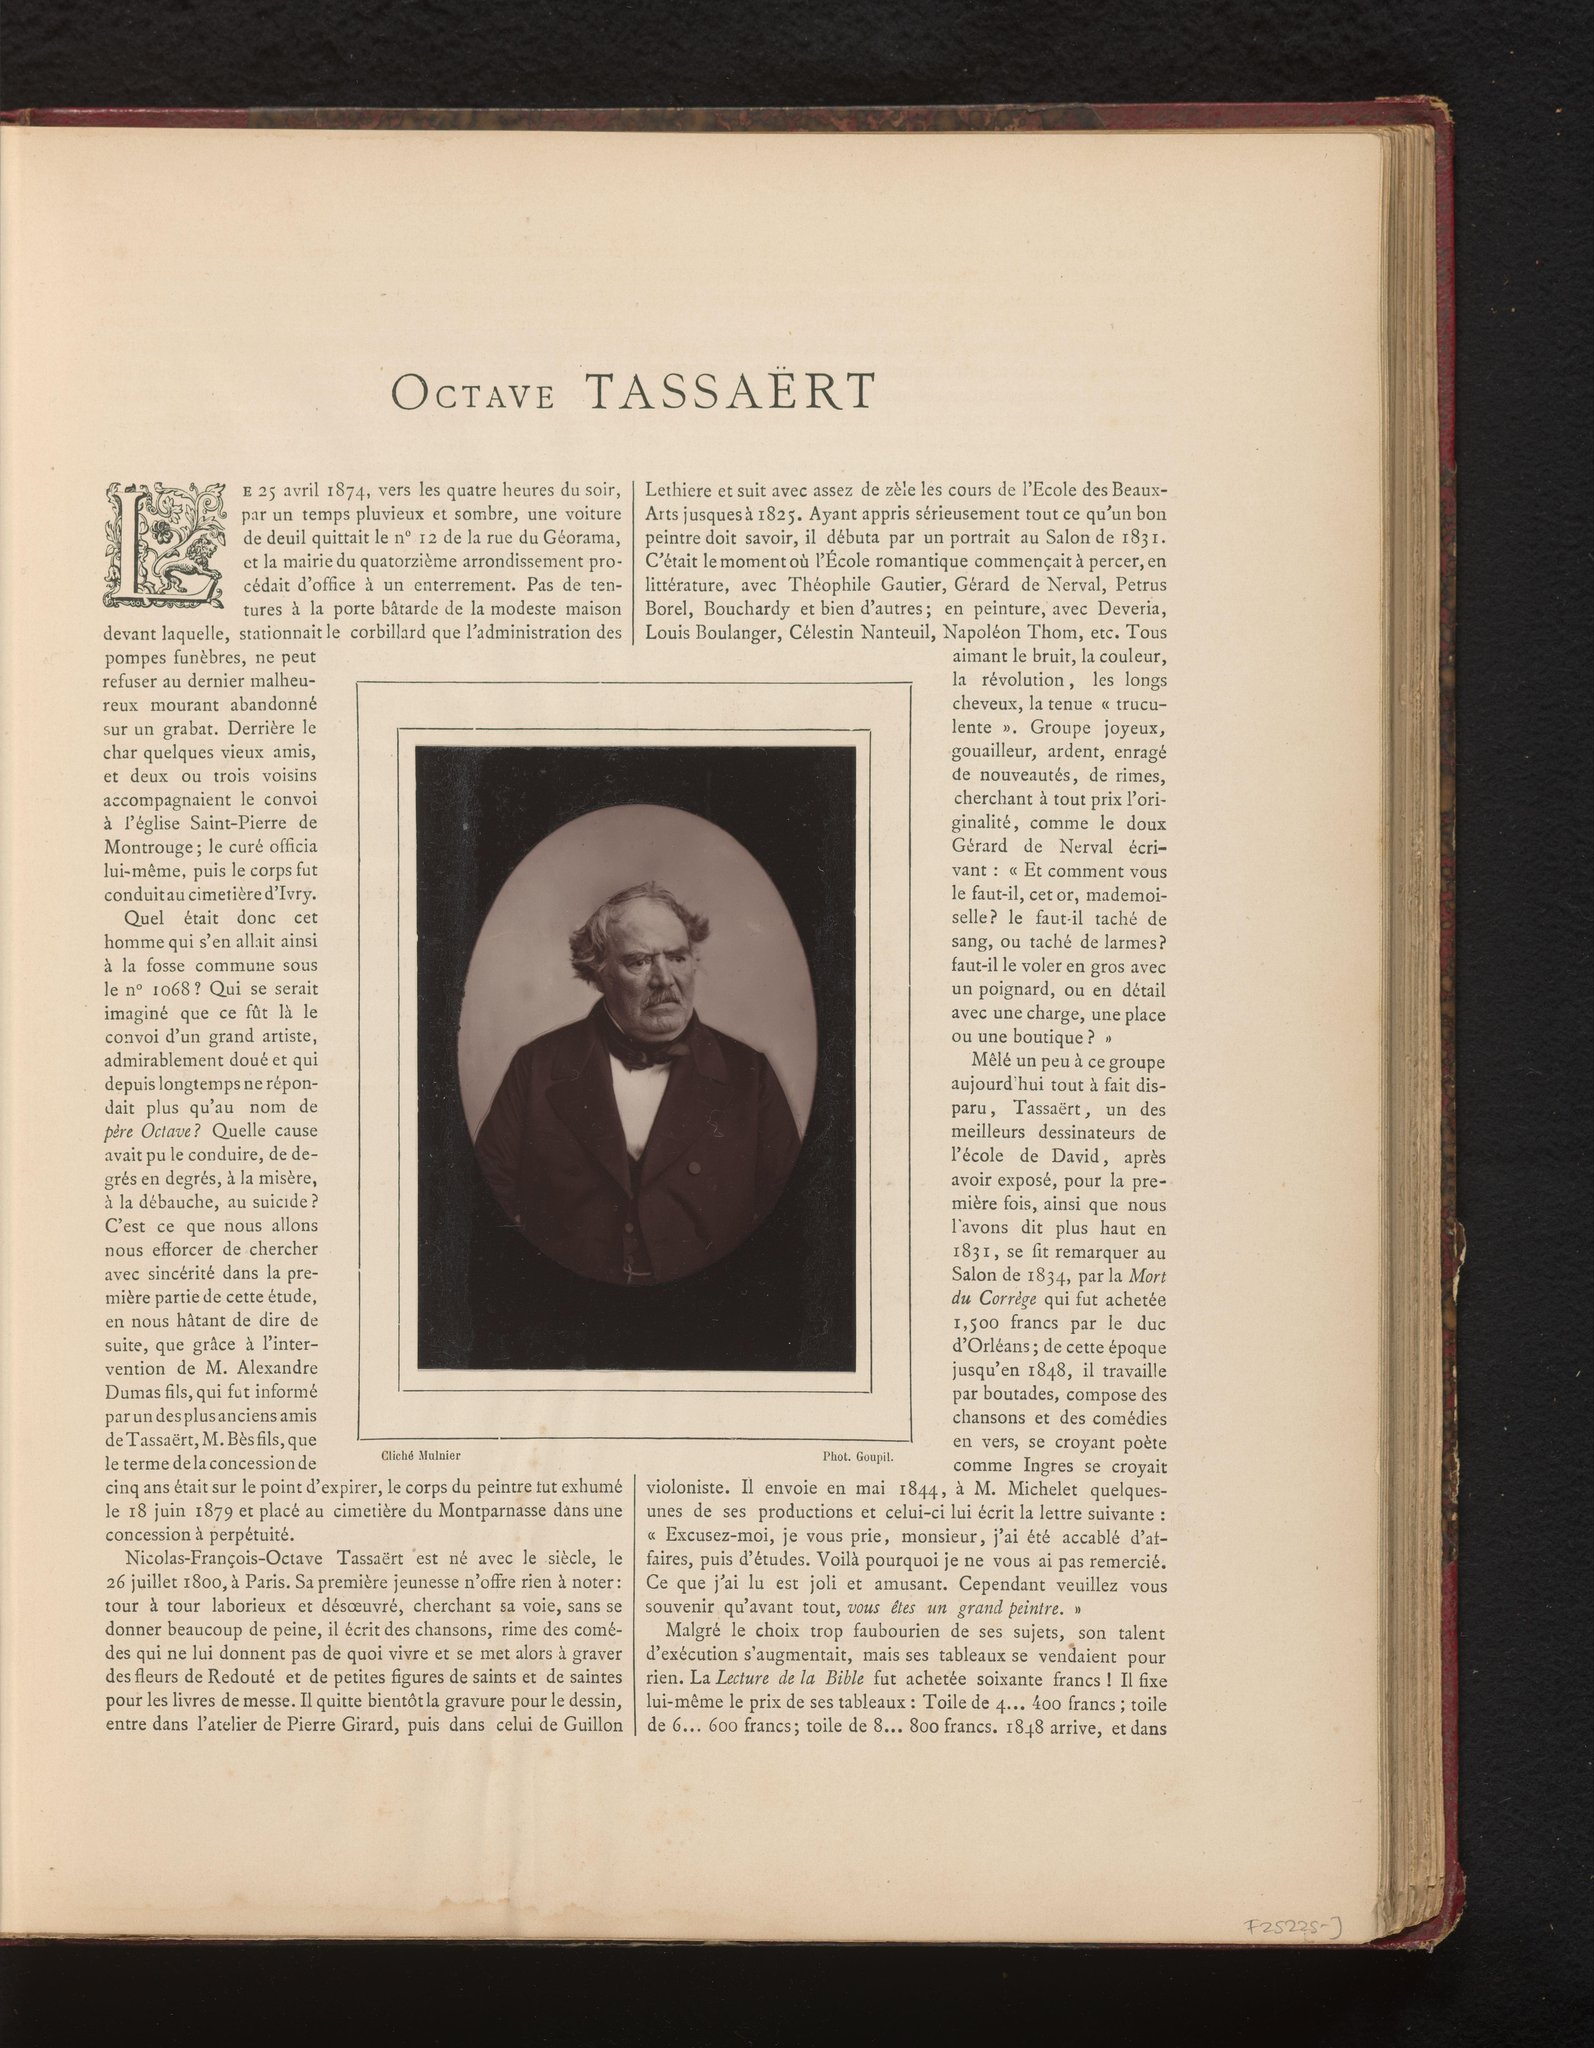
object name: page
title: Portret van Nicolas Tassaert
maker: ferdinand mulnier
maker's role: painter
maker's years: 1817-1891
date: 1876-1881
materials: paper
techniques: woodburytype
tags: paris, painter, nicolas françois octave tassaert, historical persons